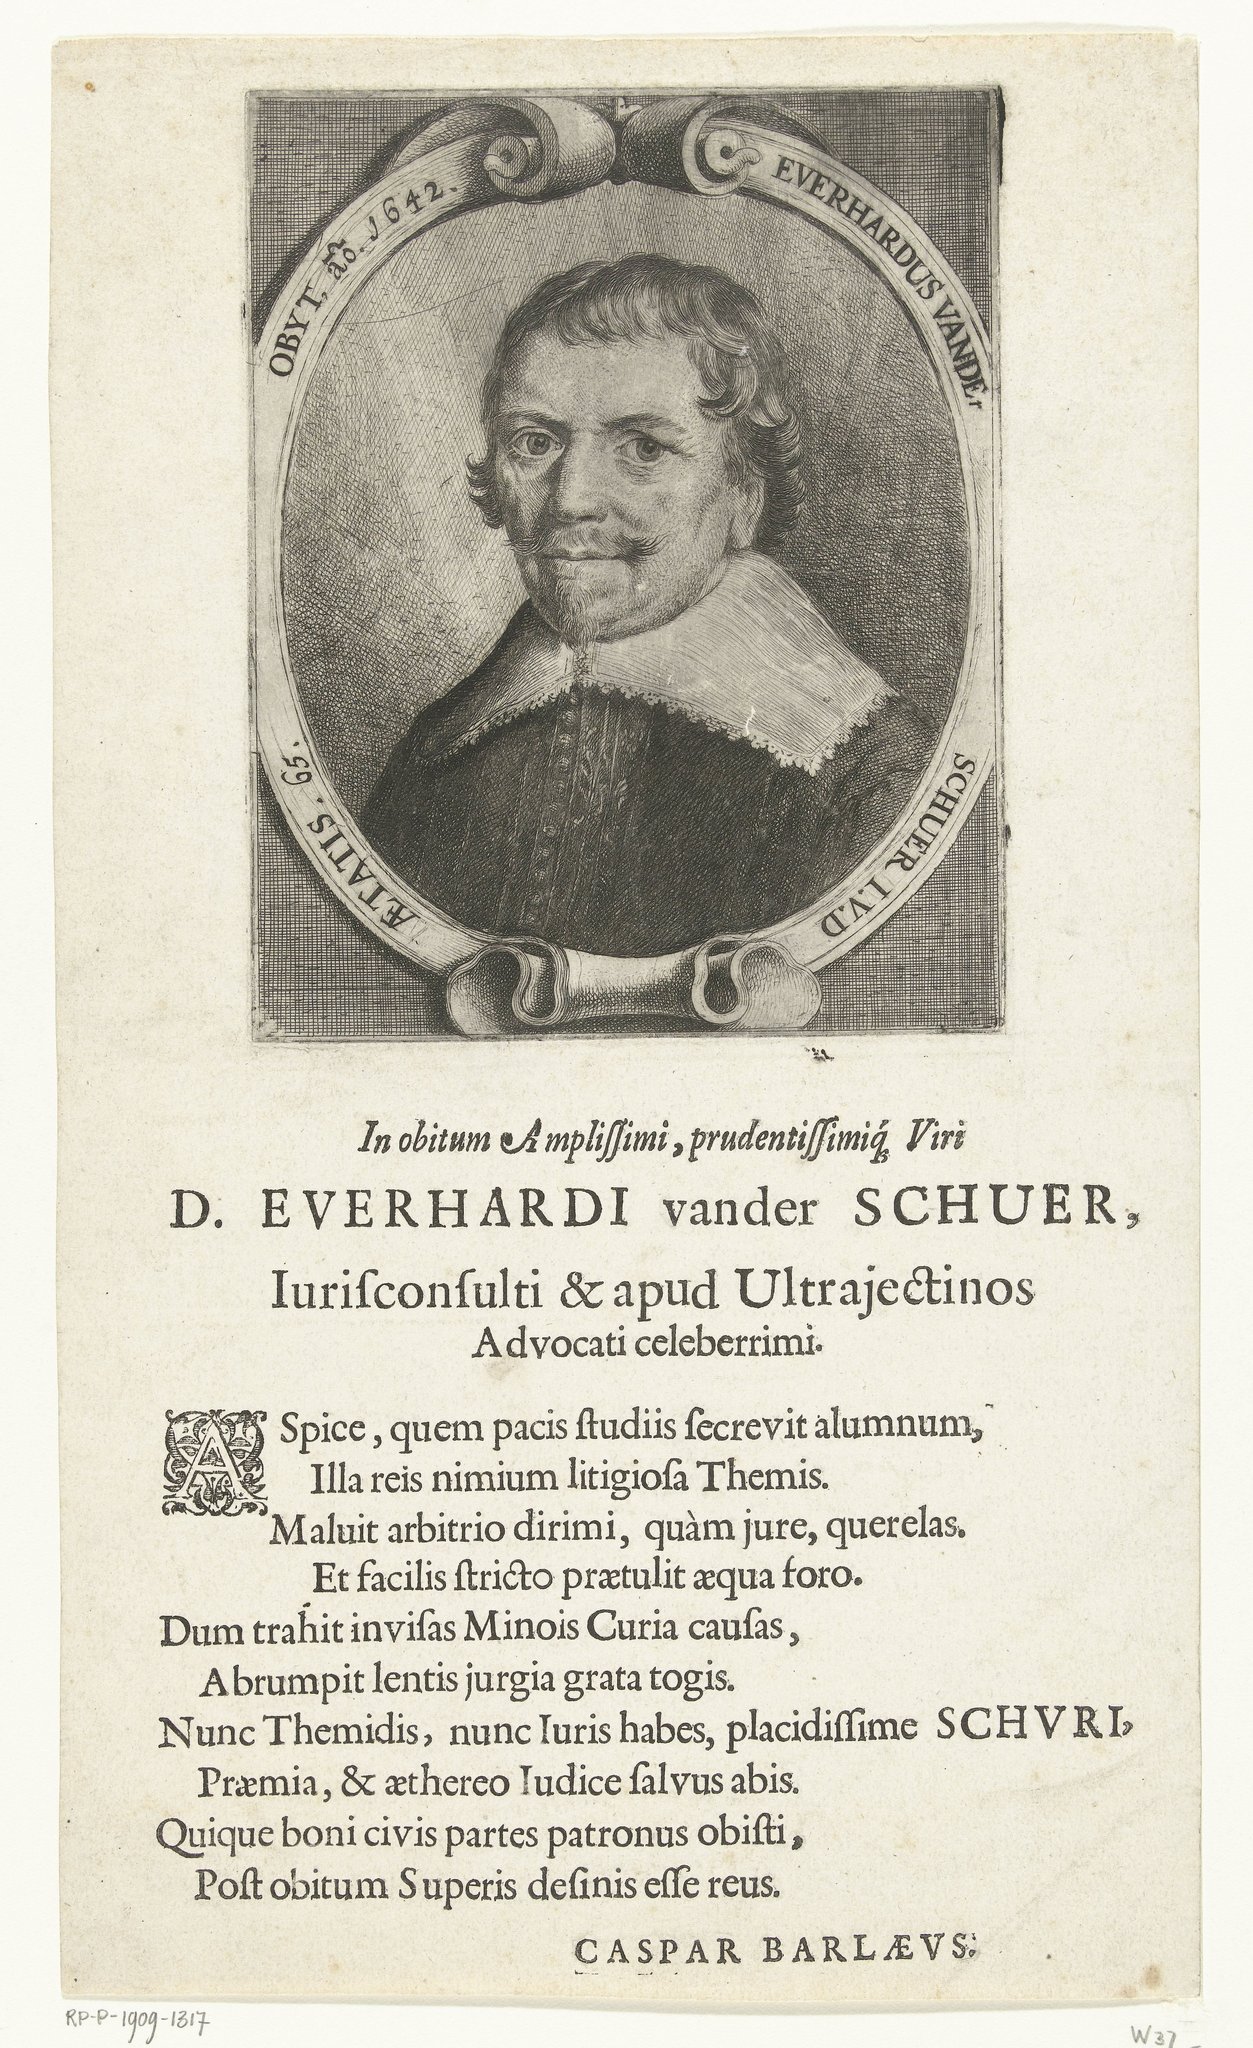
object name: print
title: Portret van Everhard van der Schuer op 65-jarige leeftijd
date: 1642-1661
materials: paper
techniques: etching, letterpress printing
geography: netherlands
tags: lawyer, attorney at law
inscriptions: collector's mark: Lugt 2228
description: Portret van Everhard van der Schuer op 65-jarige leeftijd, borstbeeld in ovale omlijsting met rolwerk. Onder het portret staat in boekdruk een vers van de schrijver Caspar van Baerle.